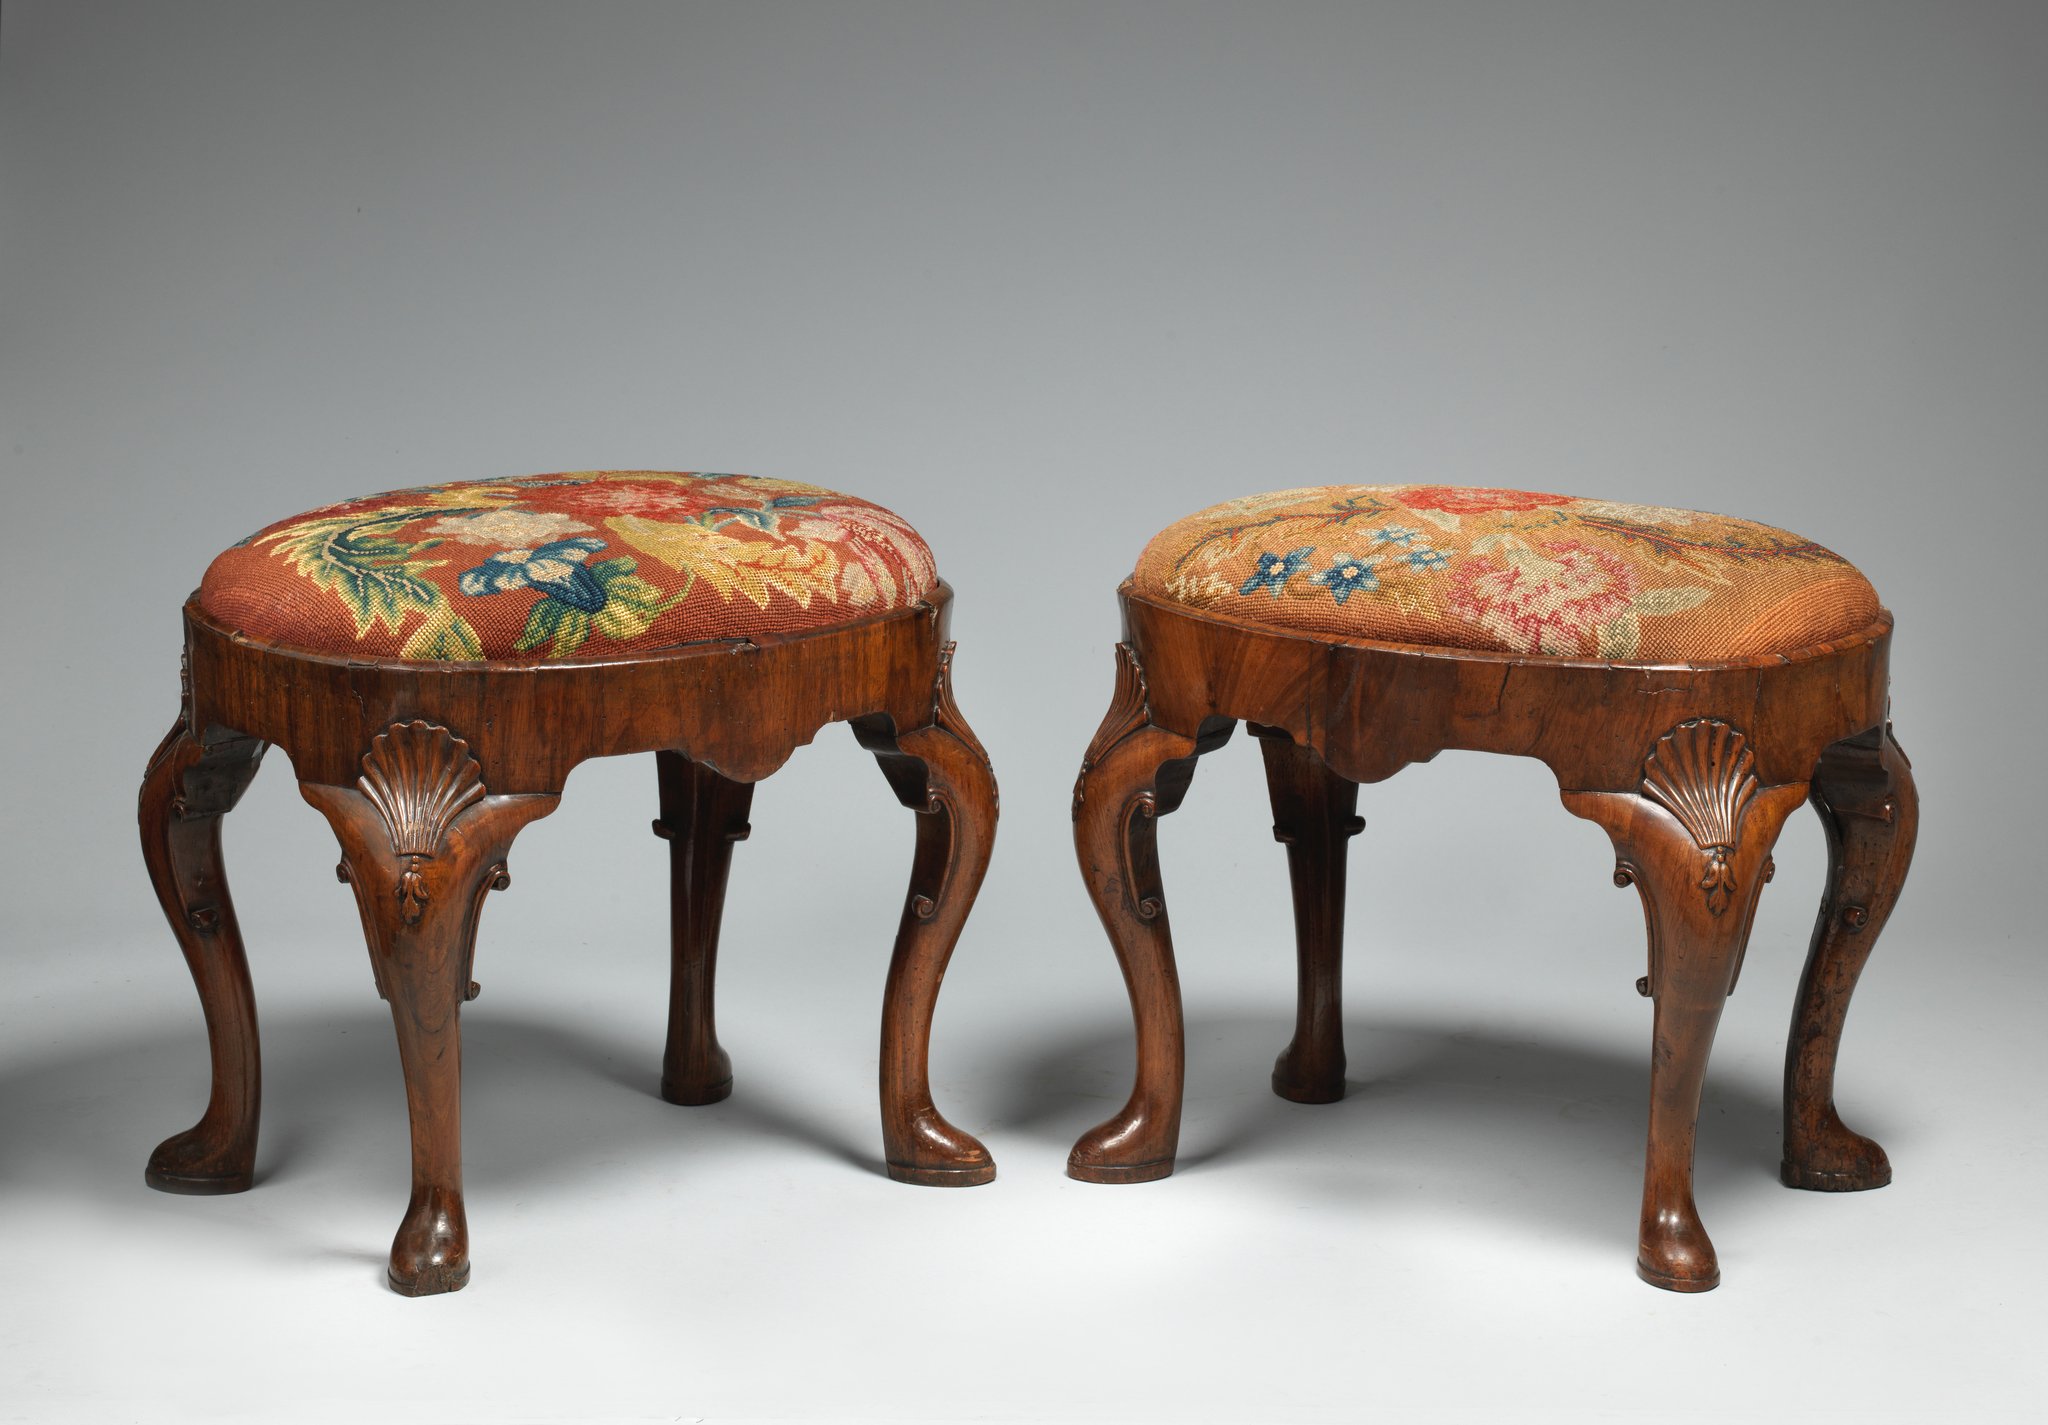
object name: stool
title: Pair of stools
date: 1710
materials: wood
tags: flowers,stools